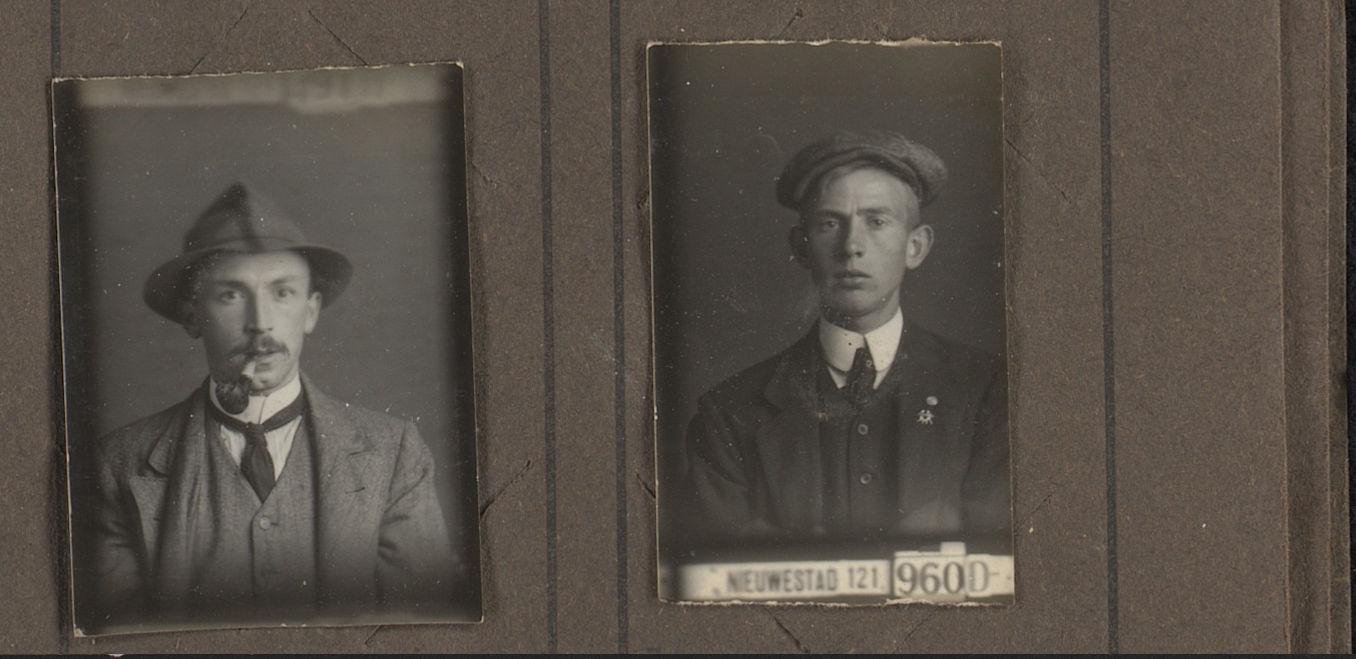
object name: snapshot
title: Portret van een onbekende jonge man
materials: paper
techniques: gelatin silver print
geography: leeuwarden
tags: anonymous historical person portrayed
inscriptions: address: ‘NIEUWESTAD 121/ 960D’